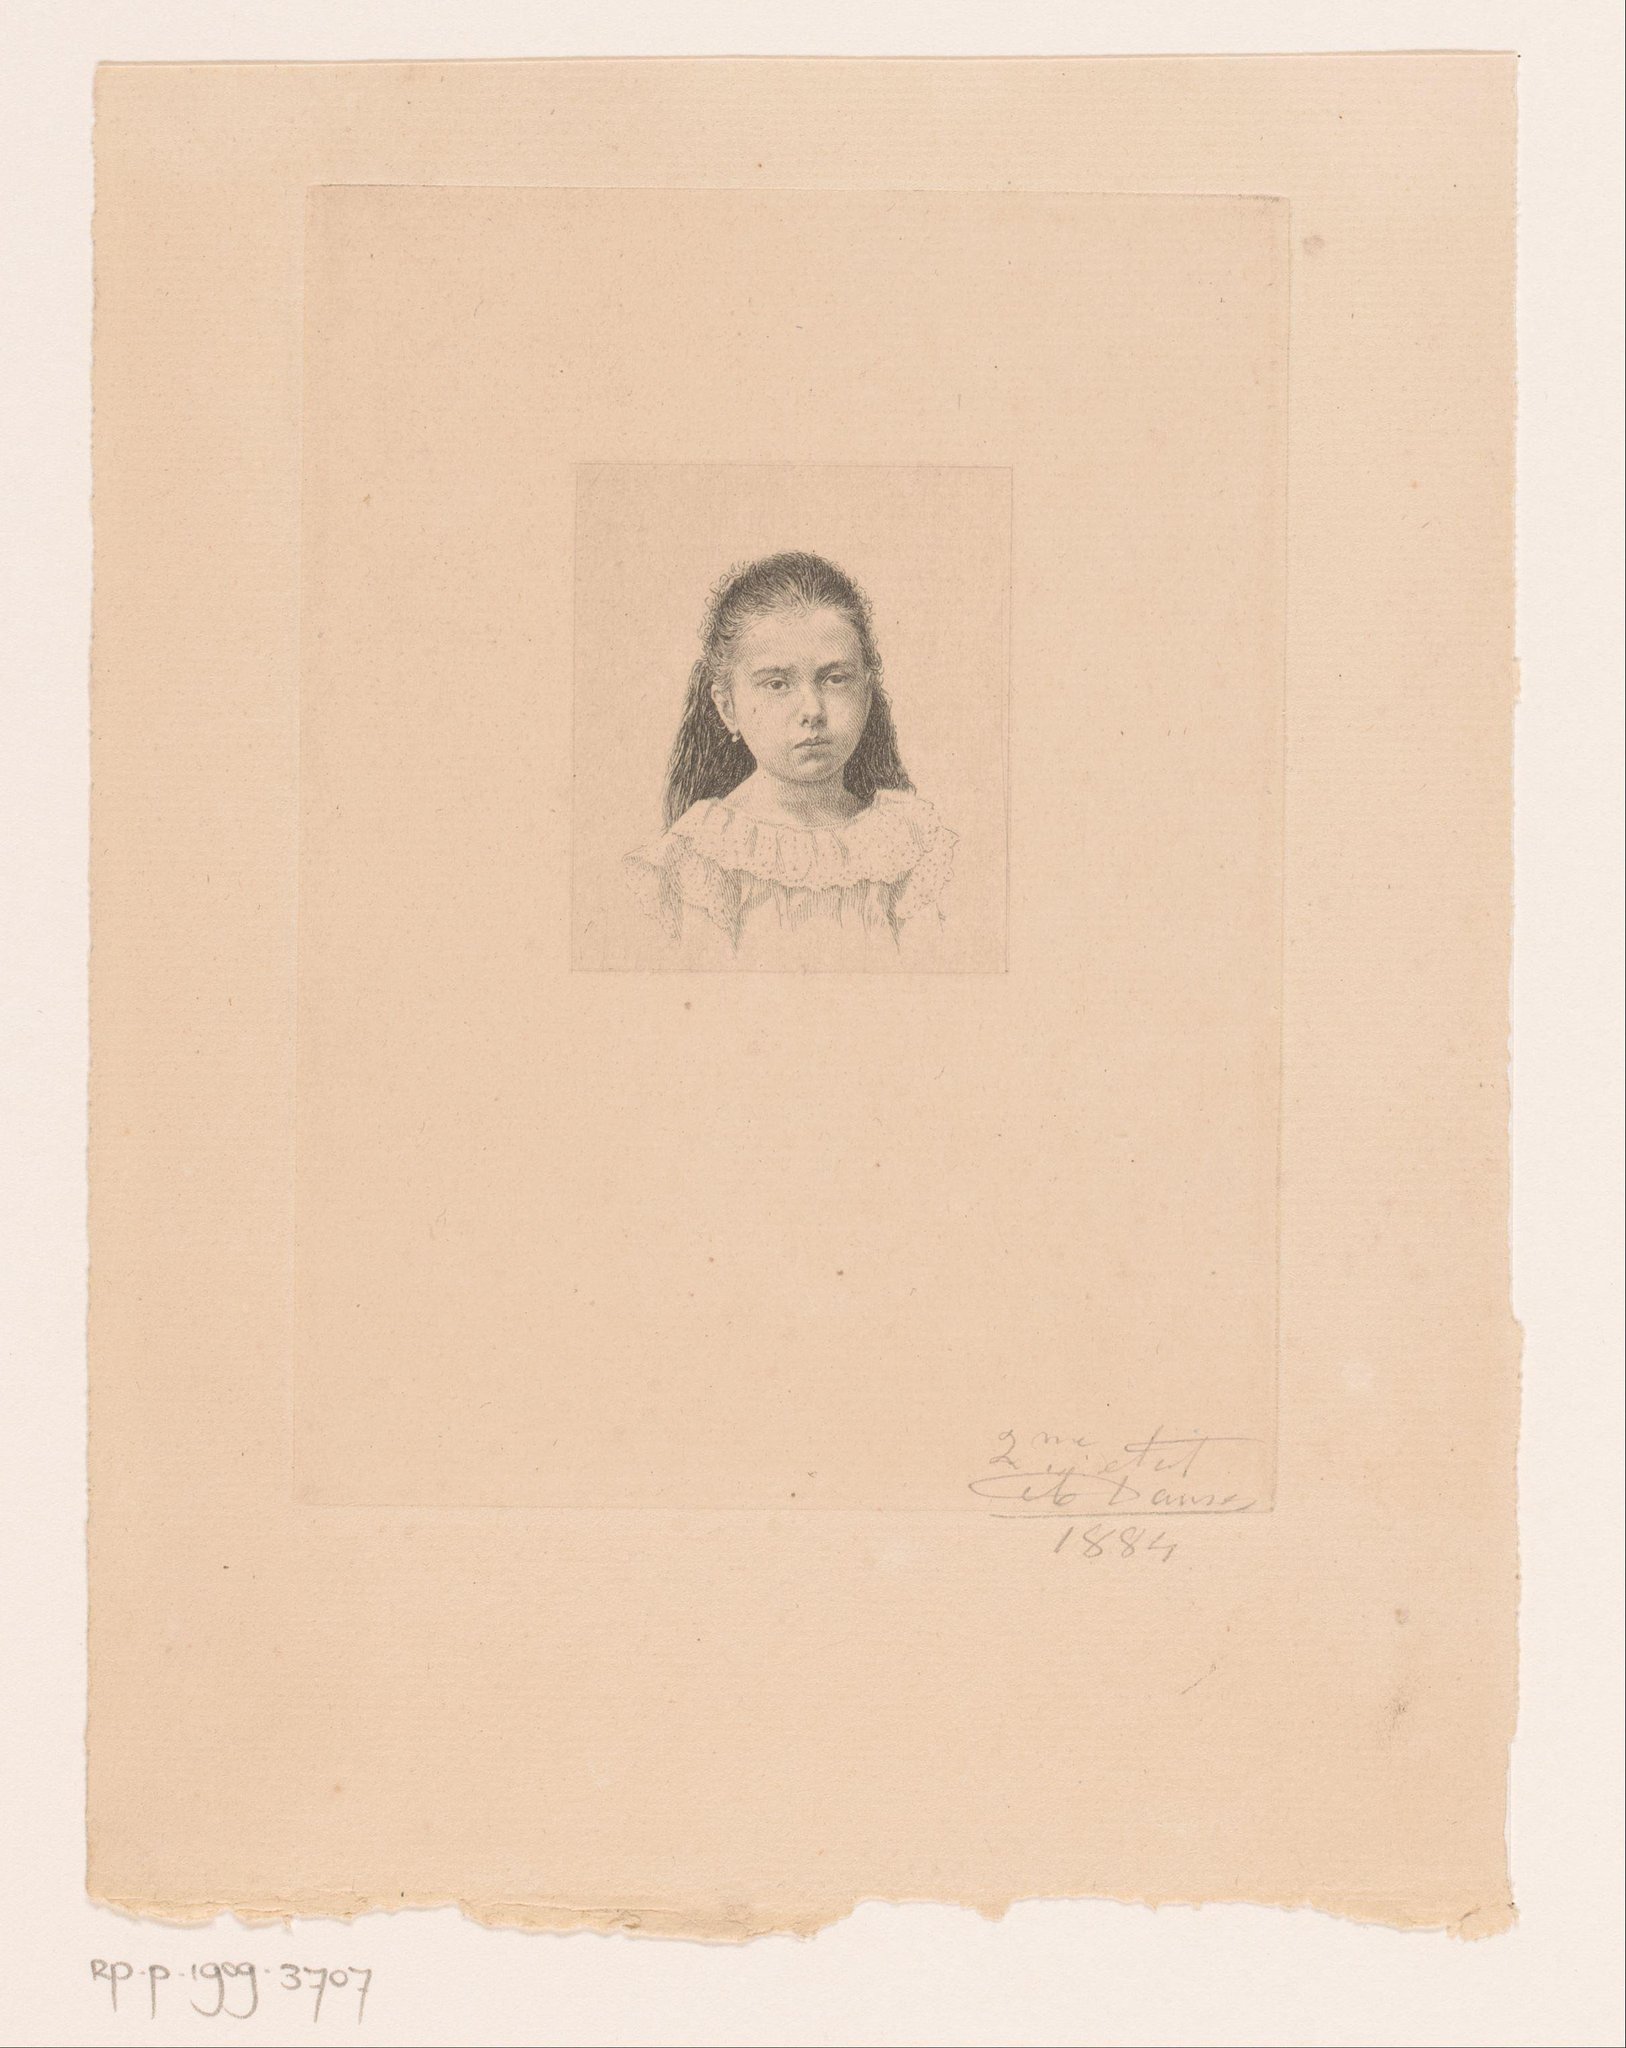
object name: print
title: Portret van een onbekend meisje met loshangend haar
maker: auguste danse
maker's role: print maker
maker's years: 1829-1929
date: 1884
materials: paper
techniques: etching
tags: adolescent, young woman, maiden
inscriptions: annotation: ‘2me etat’, collector's mark: Lugt 2228